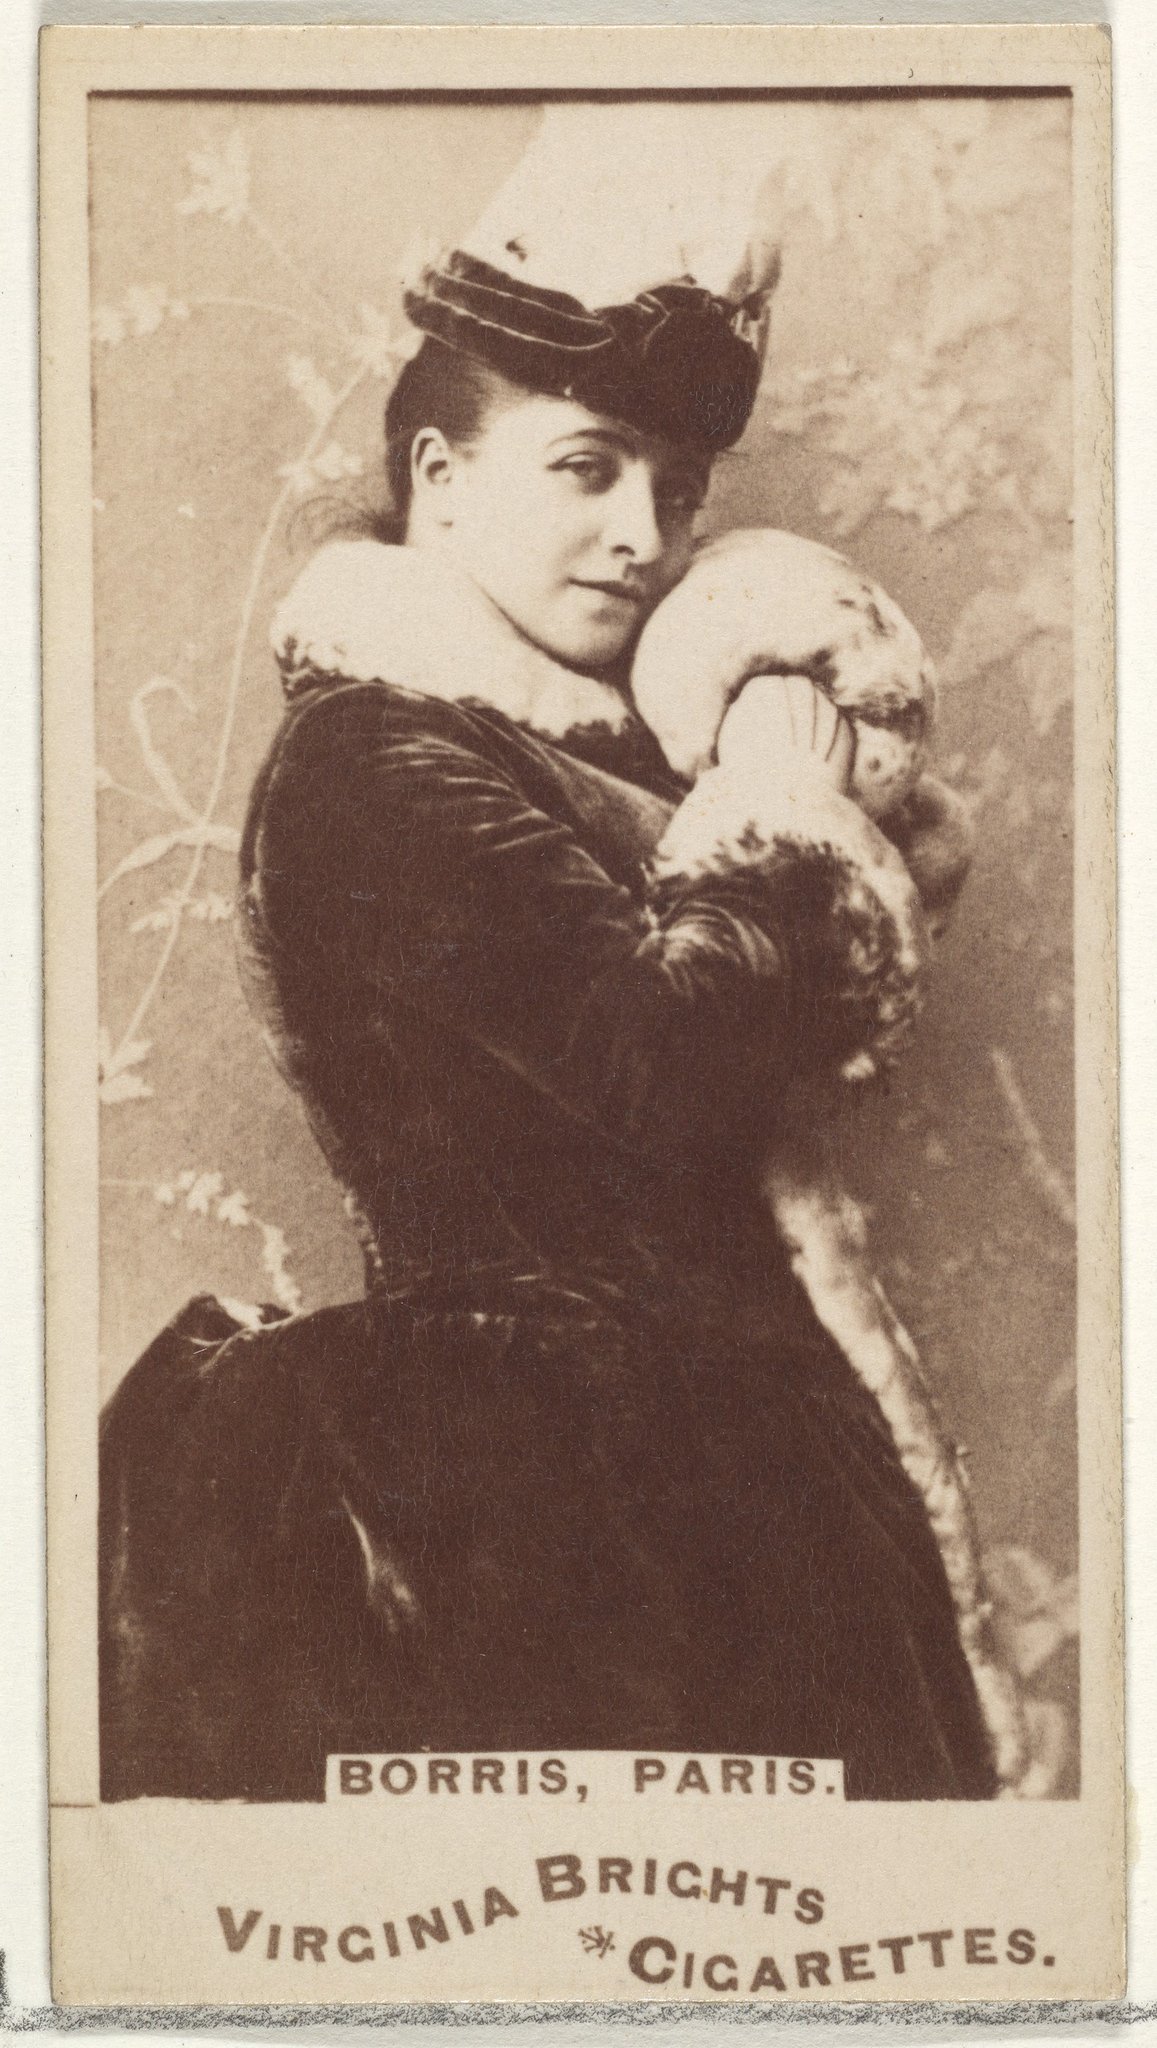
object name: photograph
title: Borris, Paris, from the Actors and Actresses series (N45, Type 1) for Virginia Brights Cigarettes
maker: allen & ginter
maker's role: publisher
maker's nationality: american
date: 1888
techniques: albumen silver print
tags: portraits,women,actresses